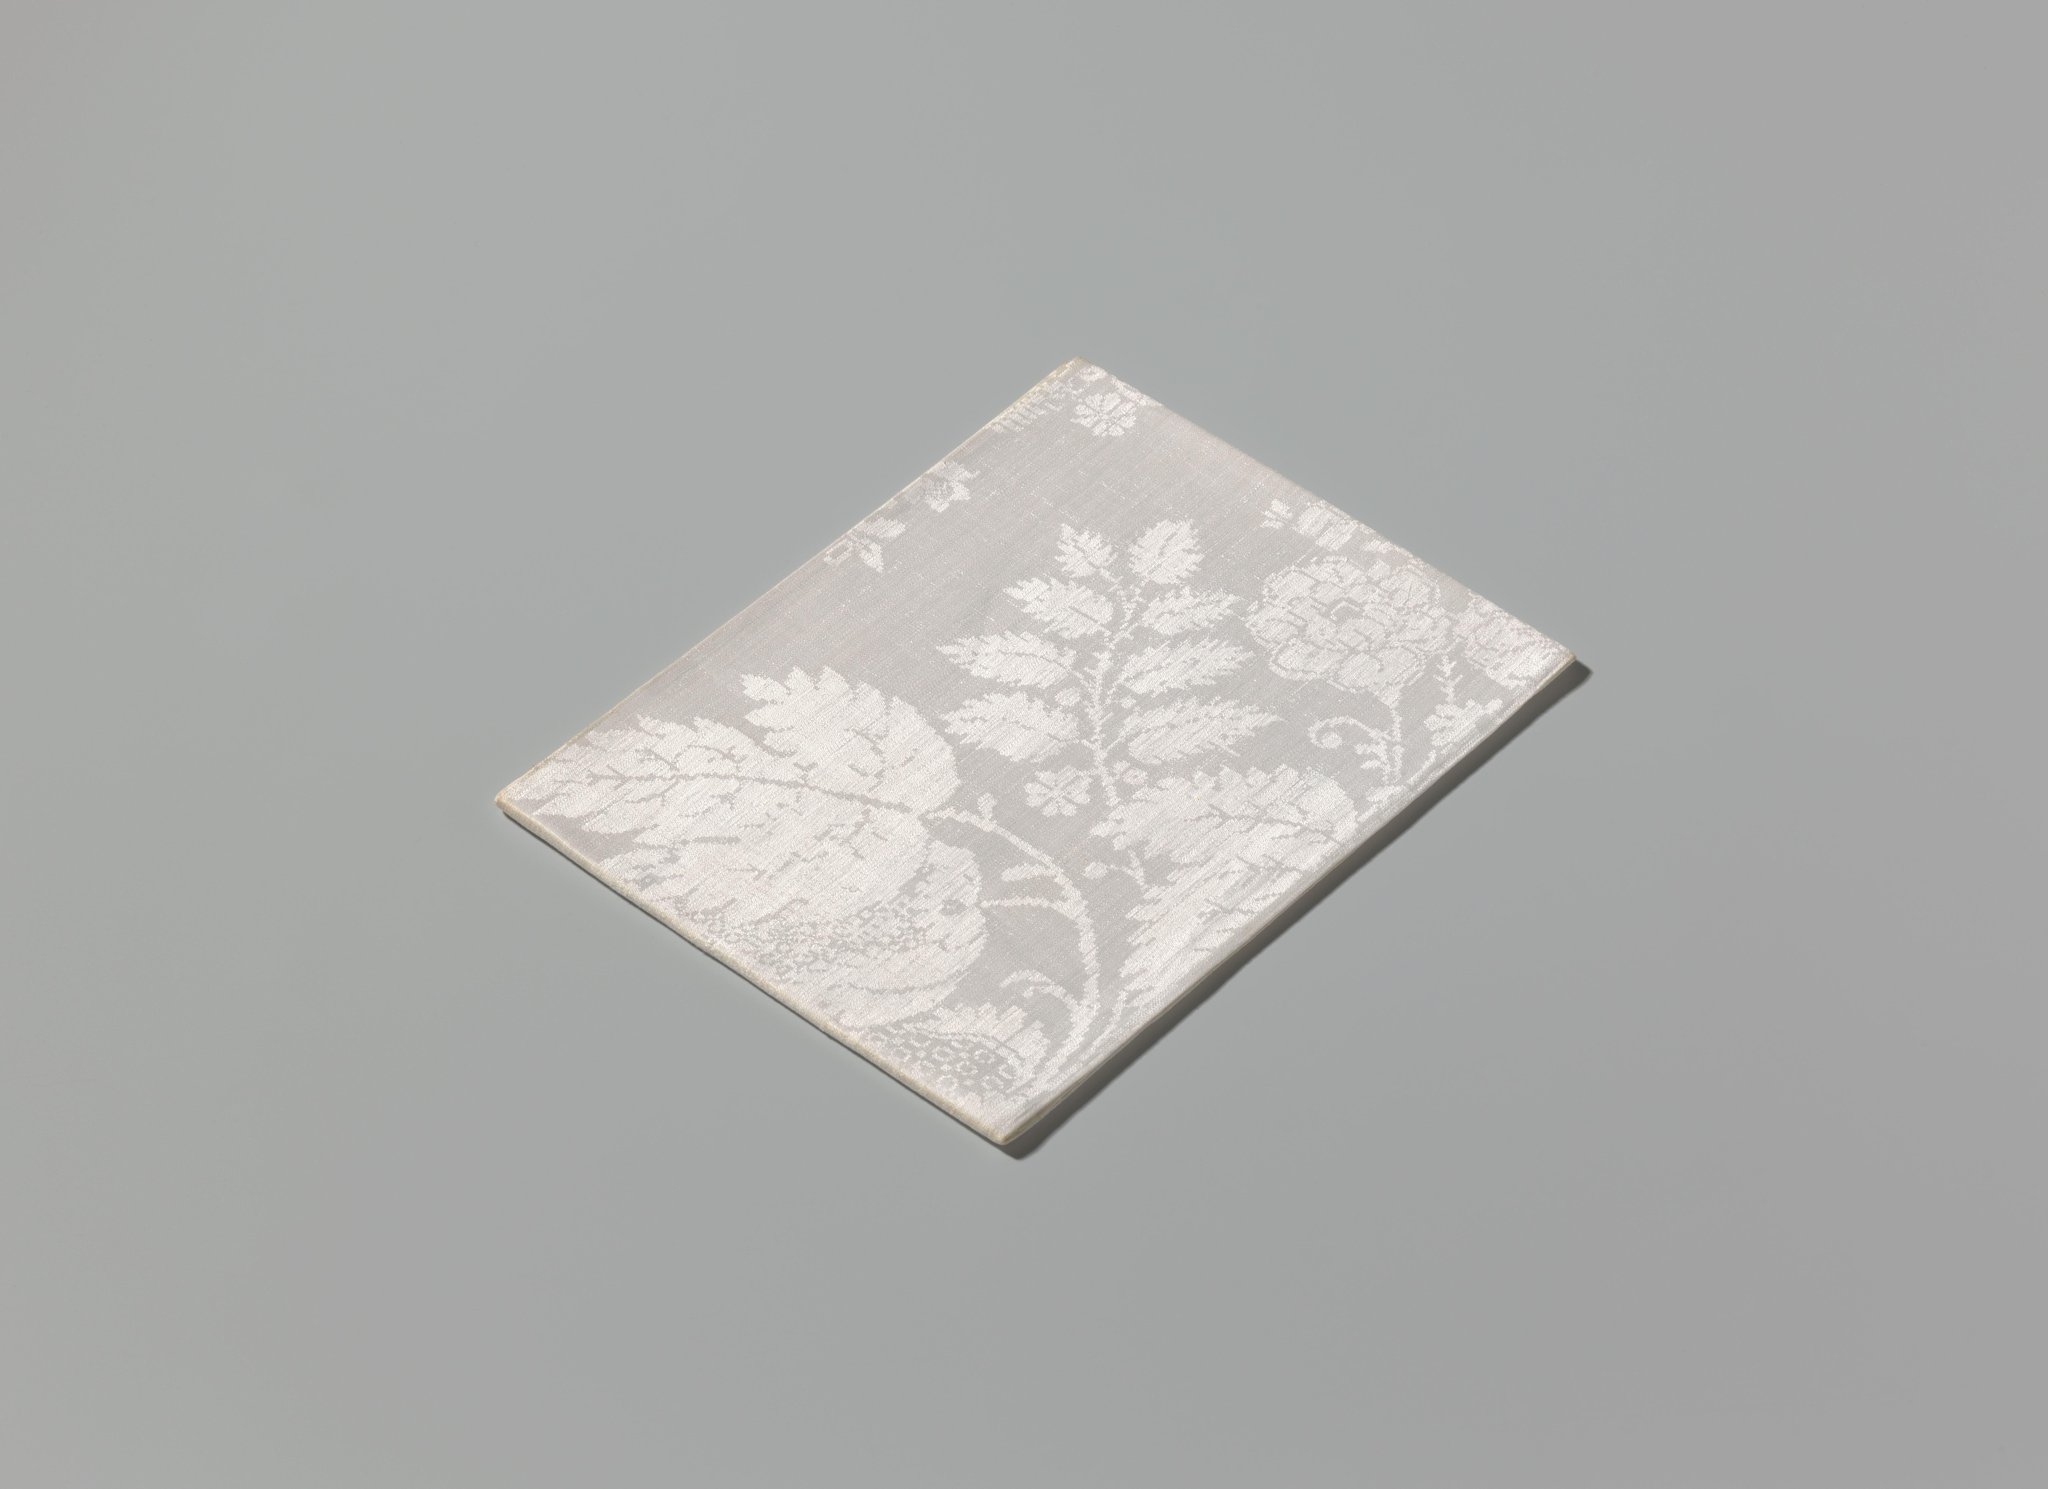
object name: napkin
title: Servet van linnendamast met een kantpatroon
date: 1725-1730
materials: linen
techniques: damask, weave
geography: northern netherlands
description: Wit linnendamasten servet met z.g. kantpatroon, merk kroon IAVG 16.